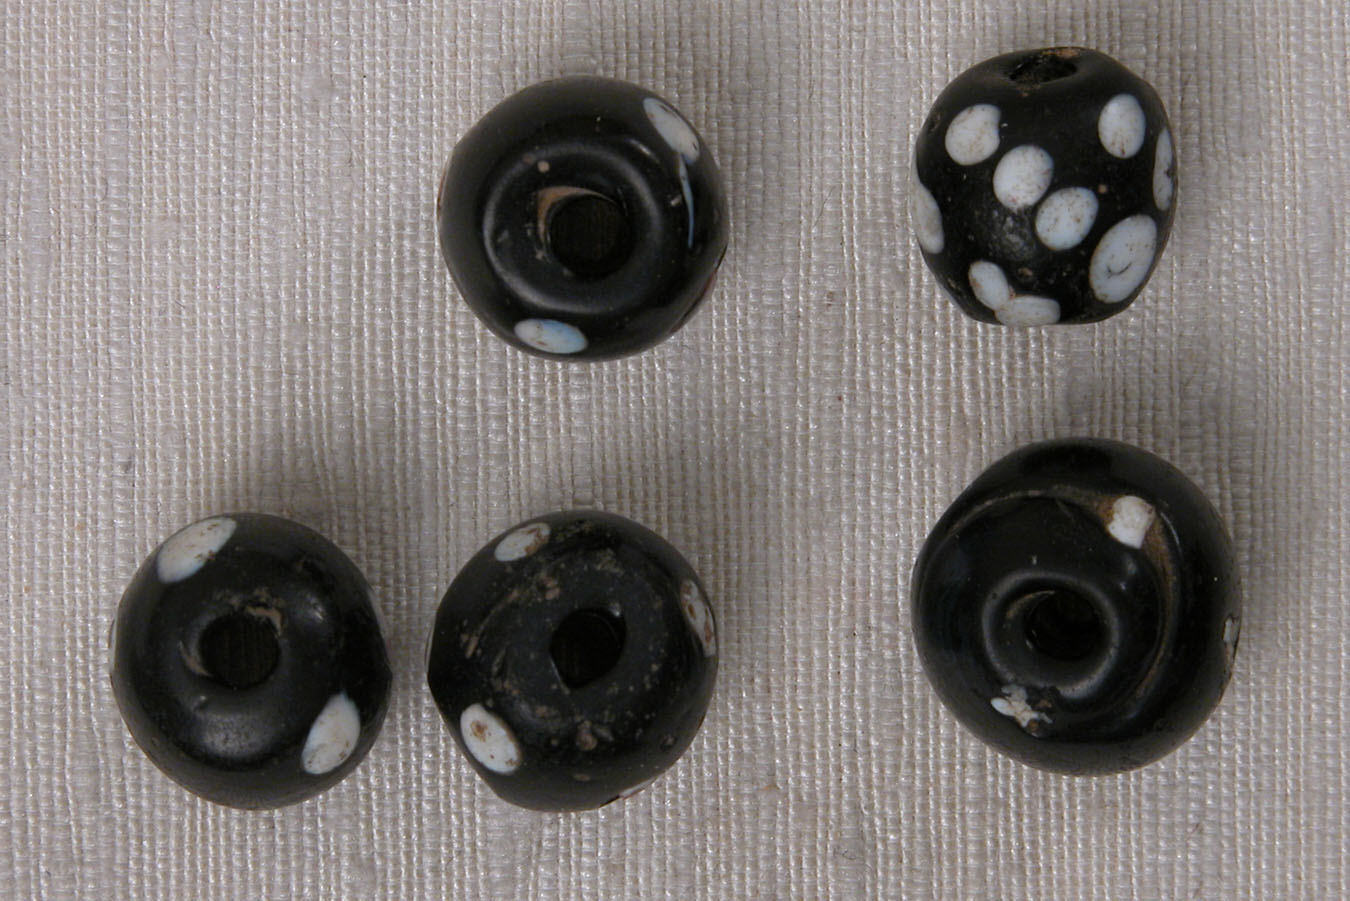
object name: bead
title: Beads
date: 801-1200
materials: glass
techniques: luster painting, stain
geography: iran